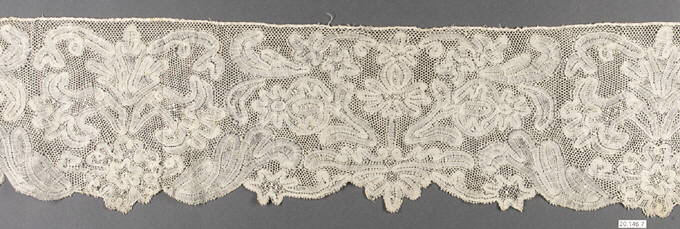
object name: piece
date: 1701-1800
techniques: lace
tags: flowers,leaves